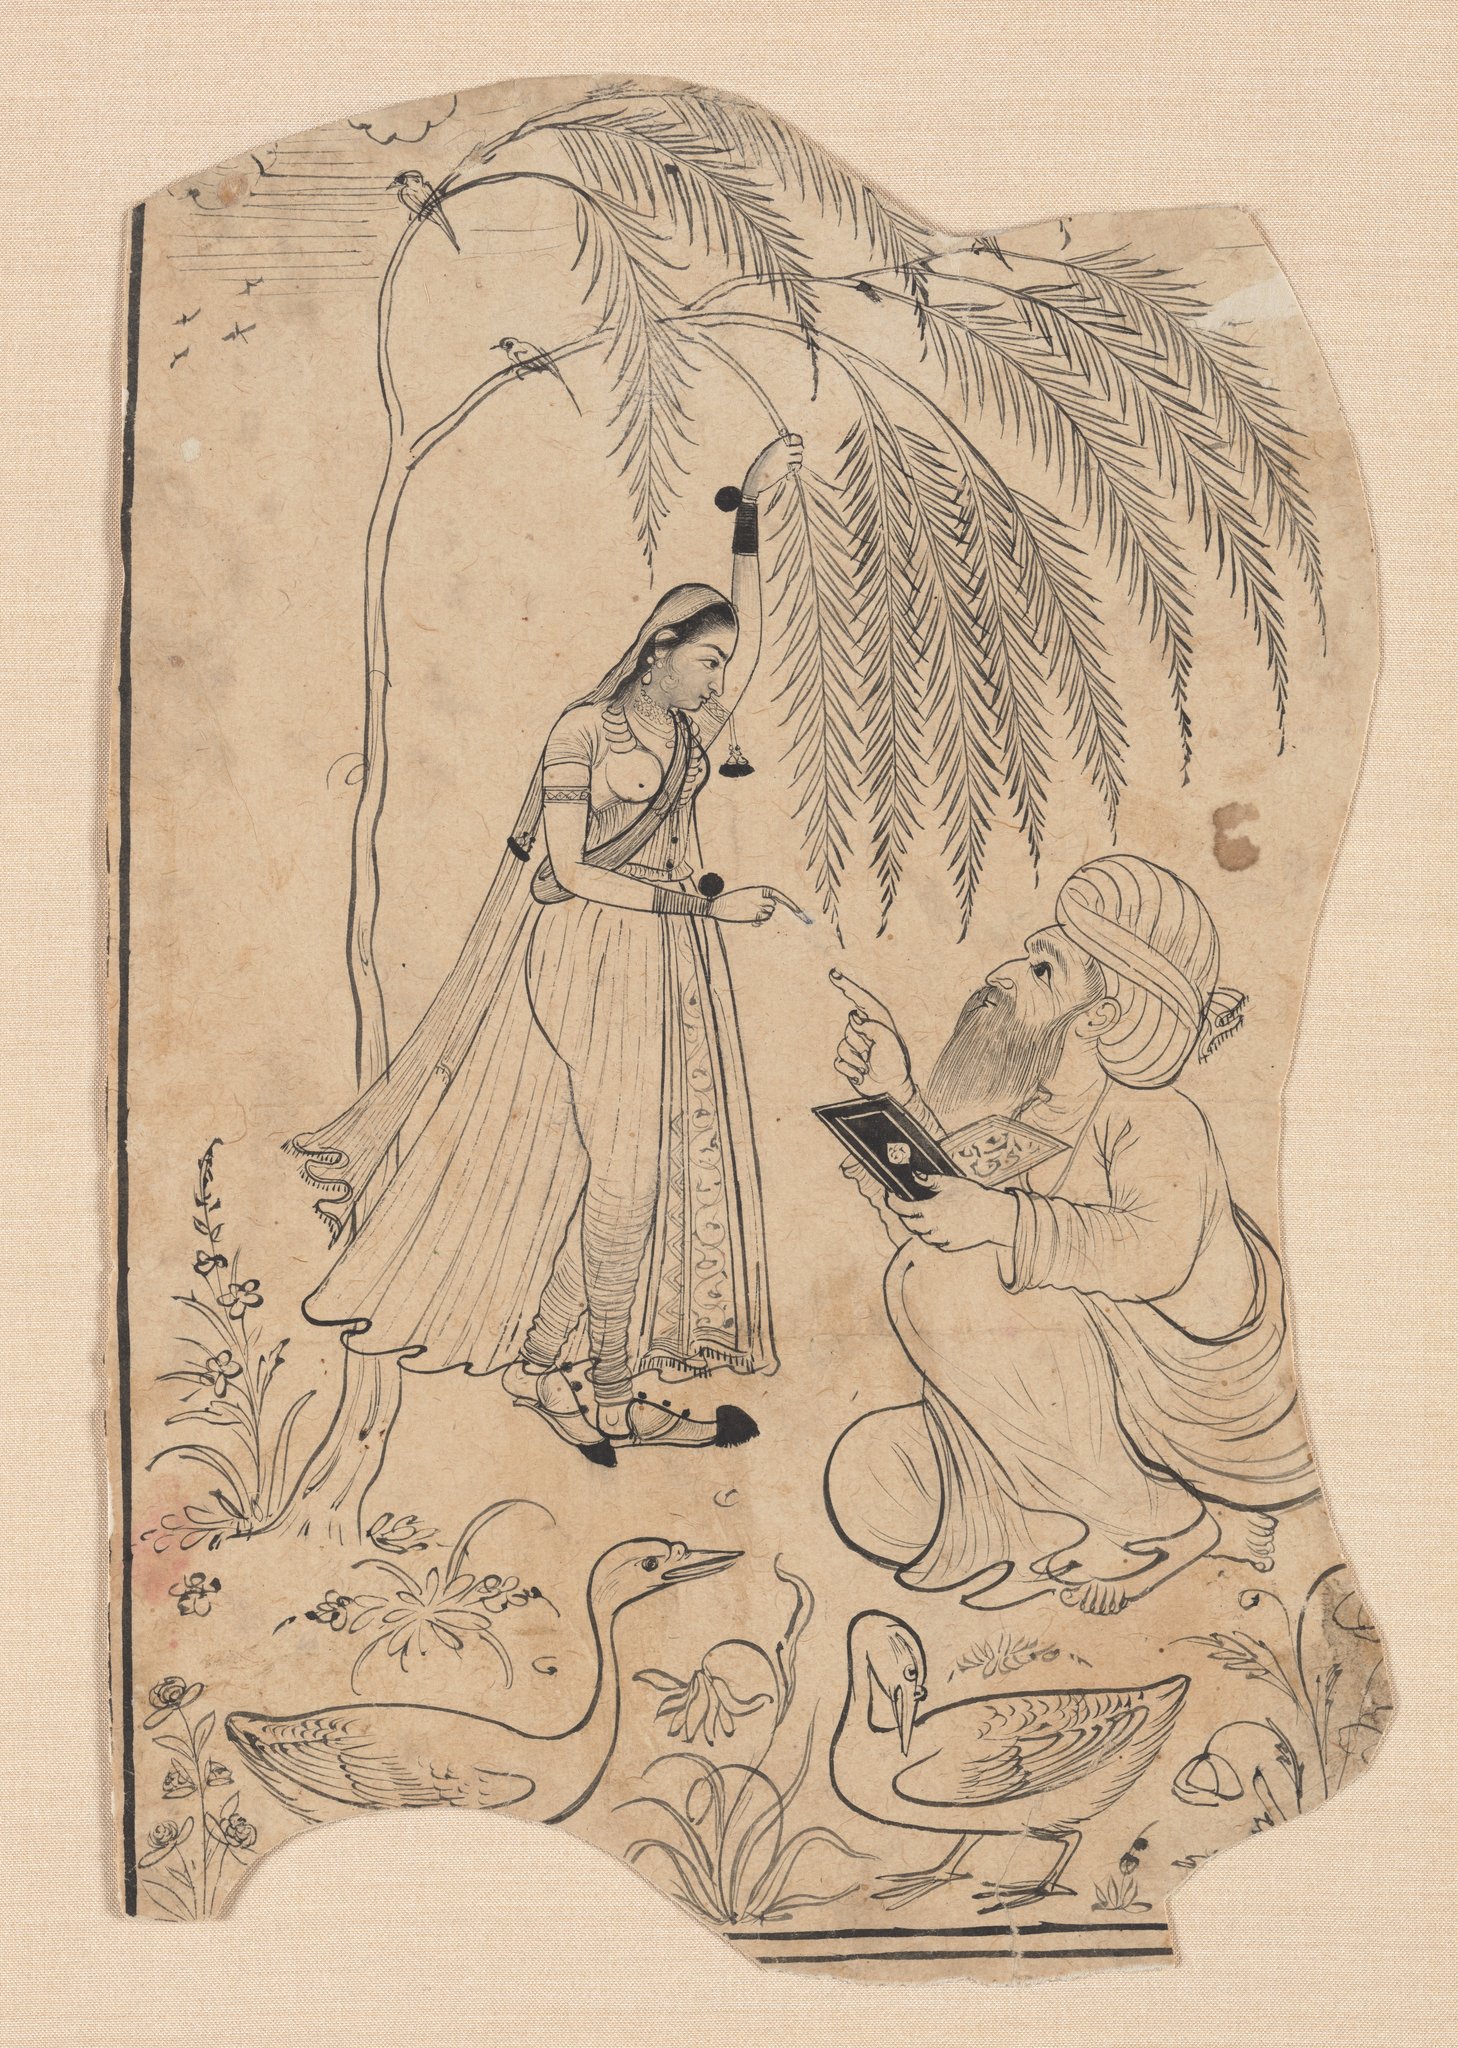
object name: illustrated single work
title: A Maiden and a Bearded Man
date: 1700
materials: ink, paper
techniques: brush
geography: india